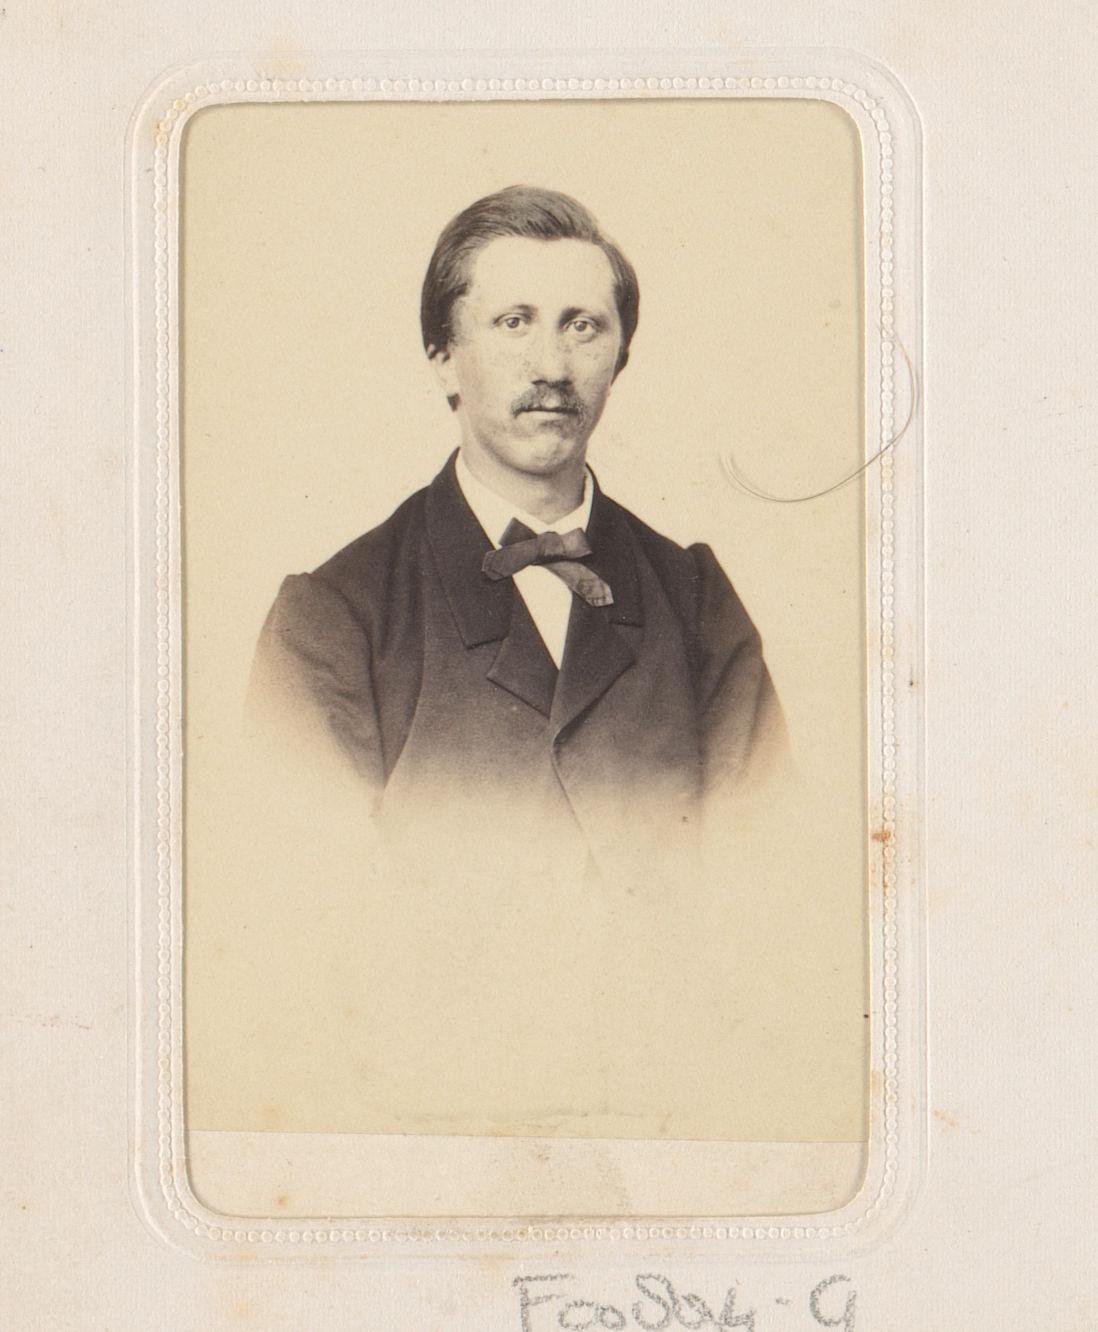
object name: album leaf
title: Portret van een man met snor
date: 1860-1890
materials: cardboard, photographic support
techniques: albumen print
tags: moustache, adult man, historical persons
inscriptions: inscription: ‘E. Flottwell/ Photographisches Atelier/ Danzig/ Reitbahn No. 7’